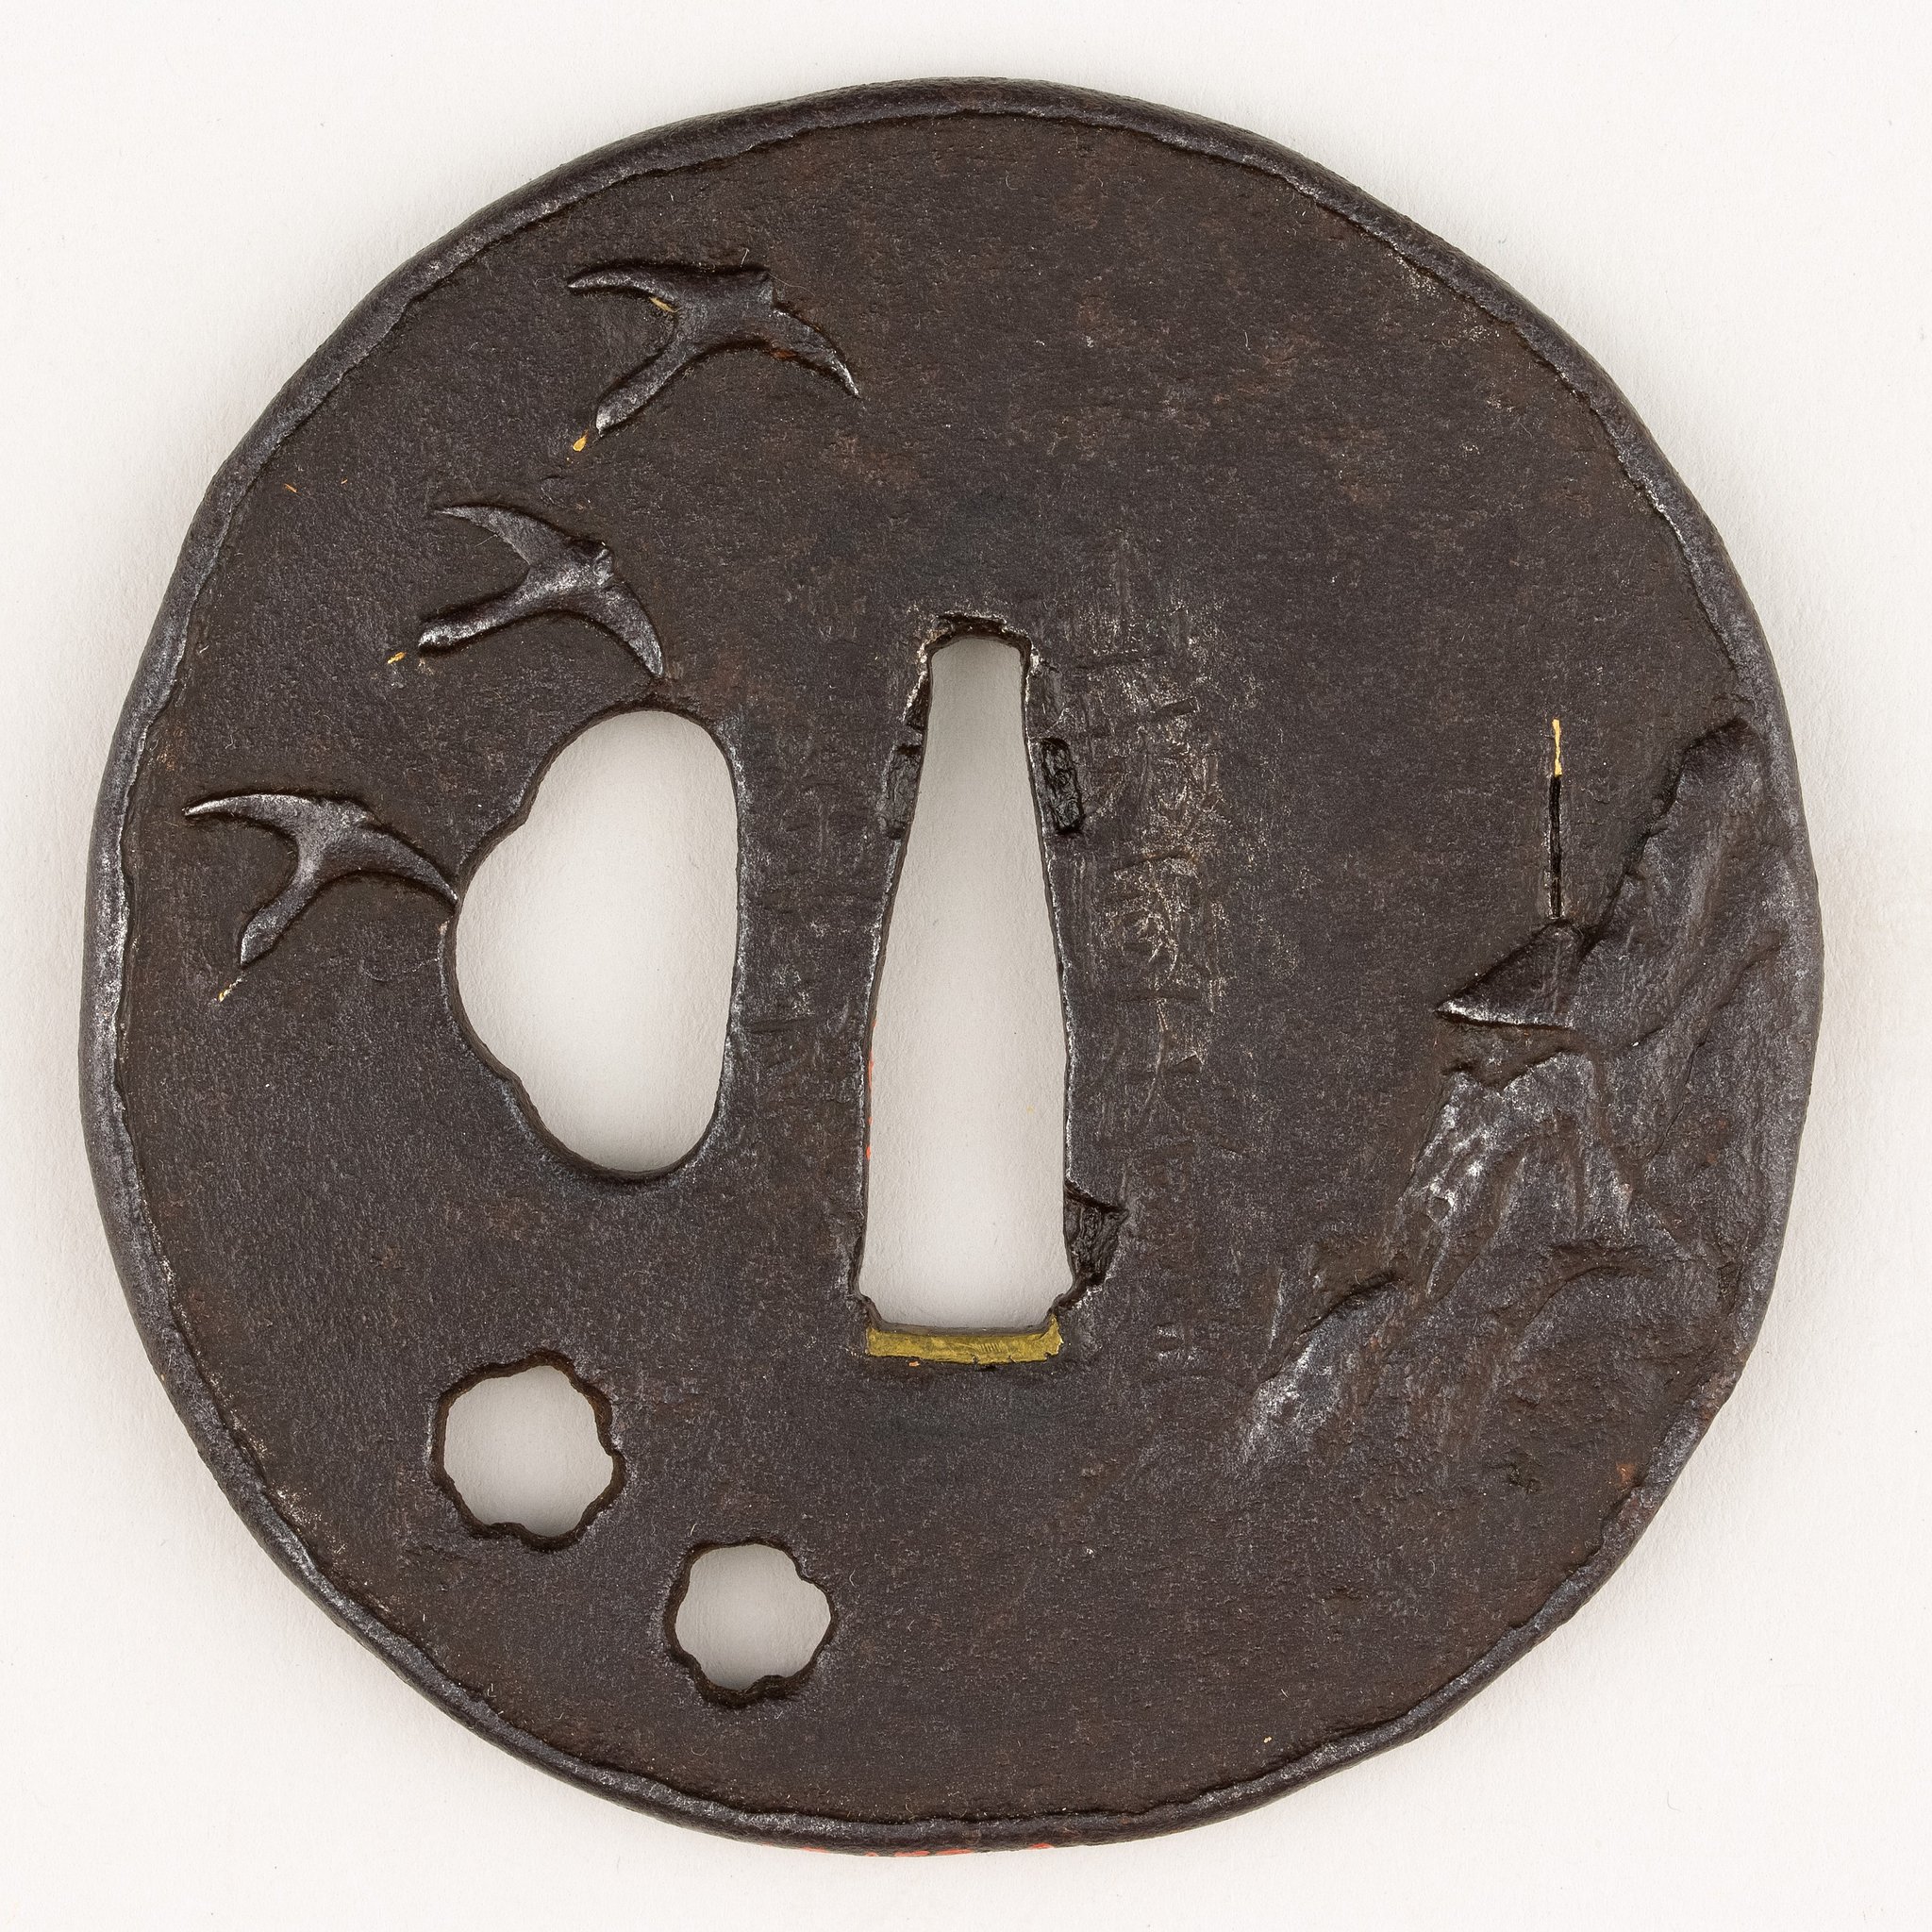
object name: sword guard tsuba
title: Sword Guard (Tsuba)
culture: japanese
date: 1615-1868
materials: iron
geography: japan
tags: birds